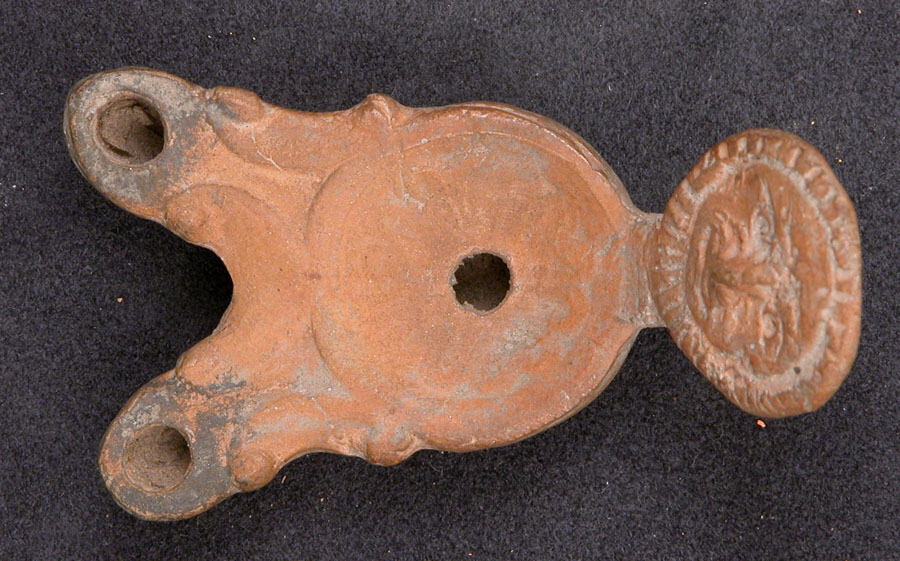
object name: lamp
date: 100 BCE-100 CE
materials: earthenware